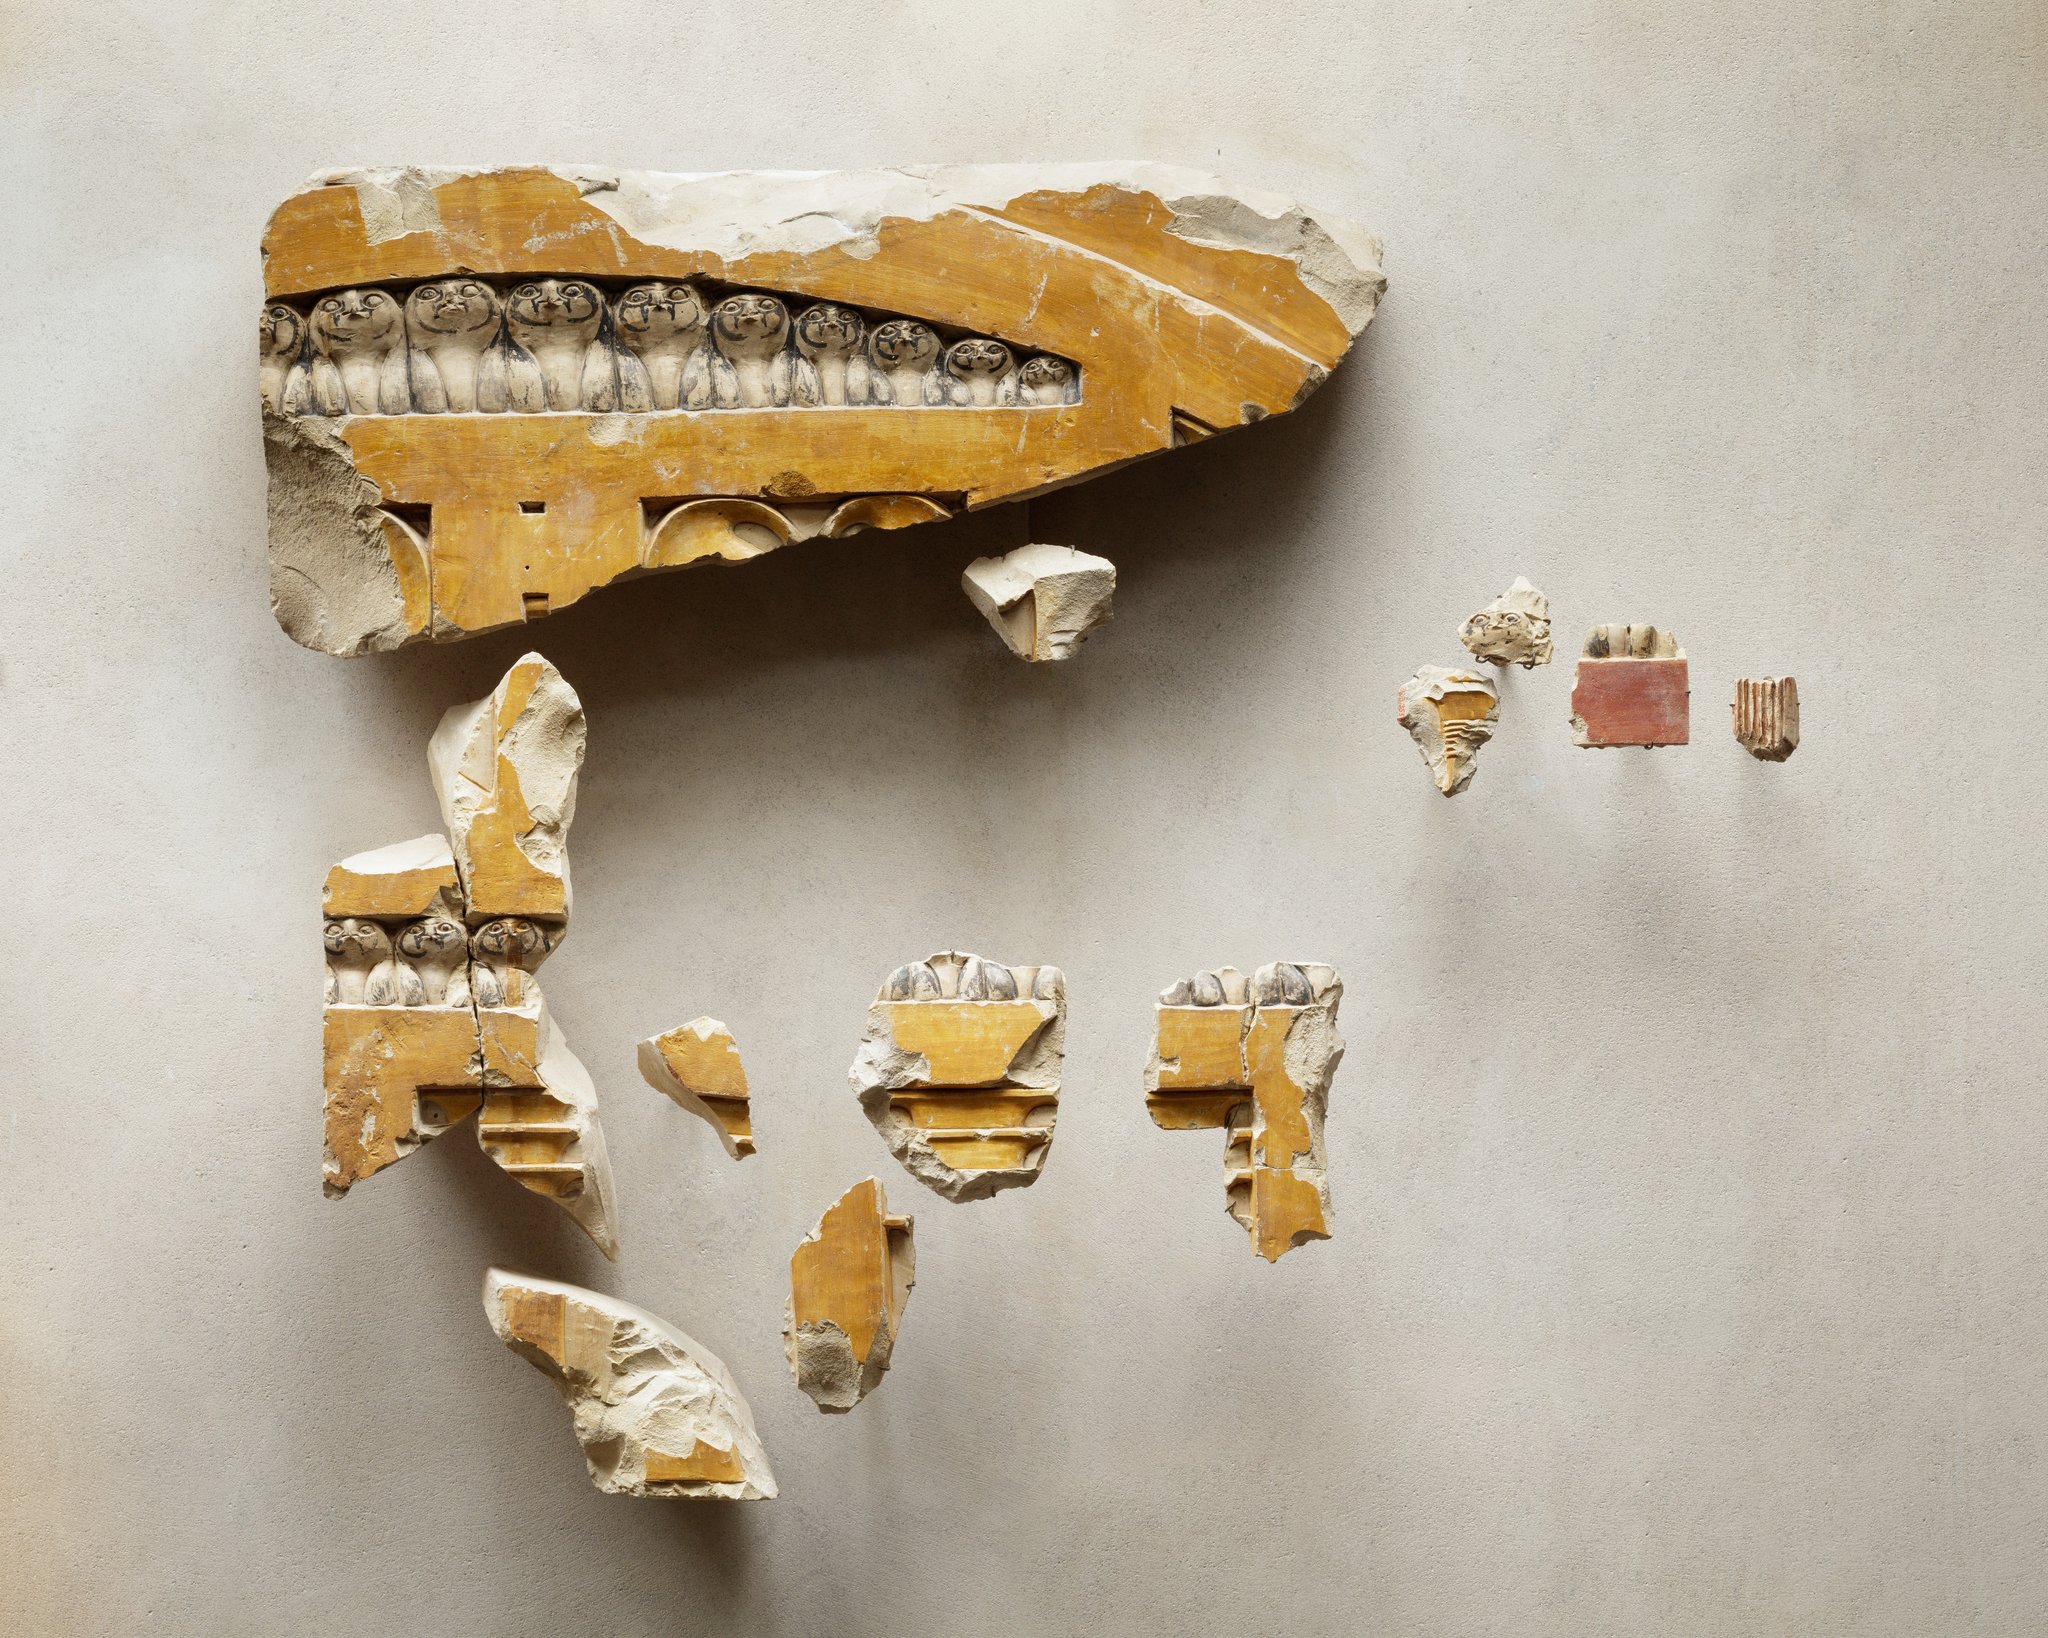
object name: relief fragment, tomb of neferu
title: Relief depicting an elaborate doorway - see 26.3.353-5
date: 2051-2030 BCE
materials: limestone, paint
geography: egypt